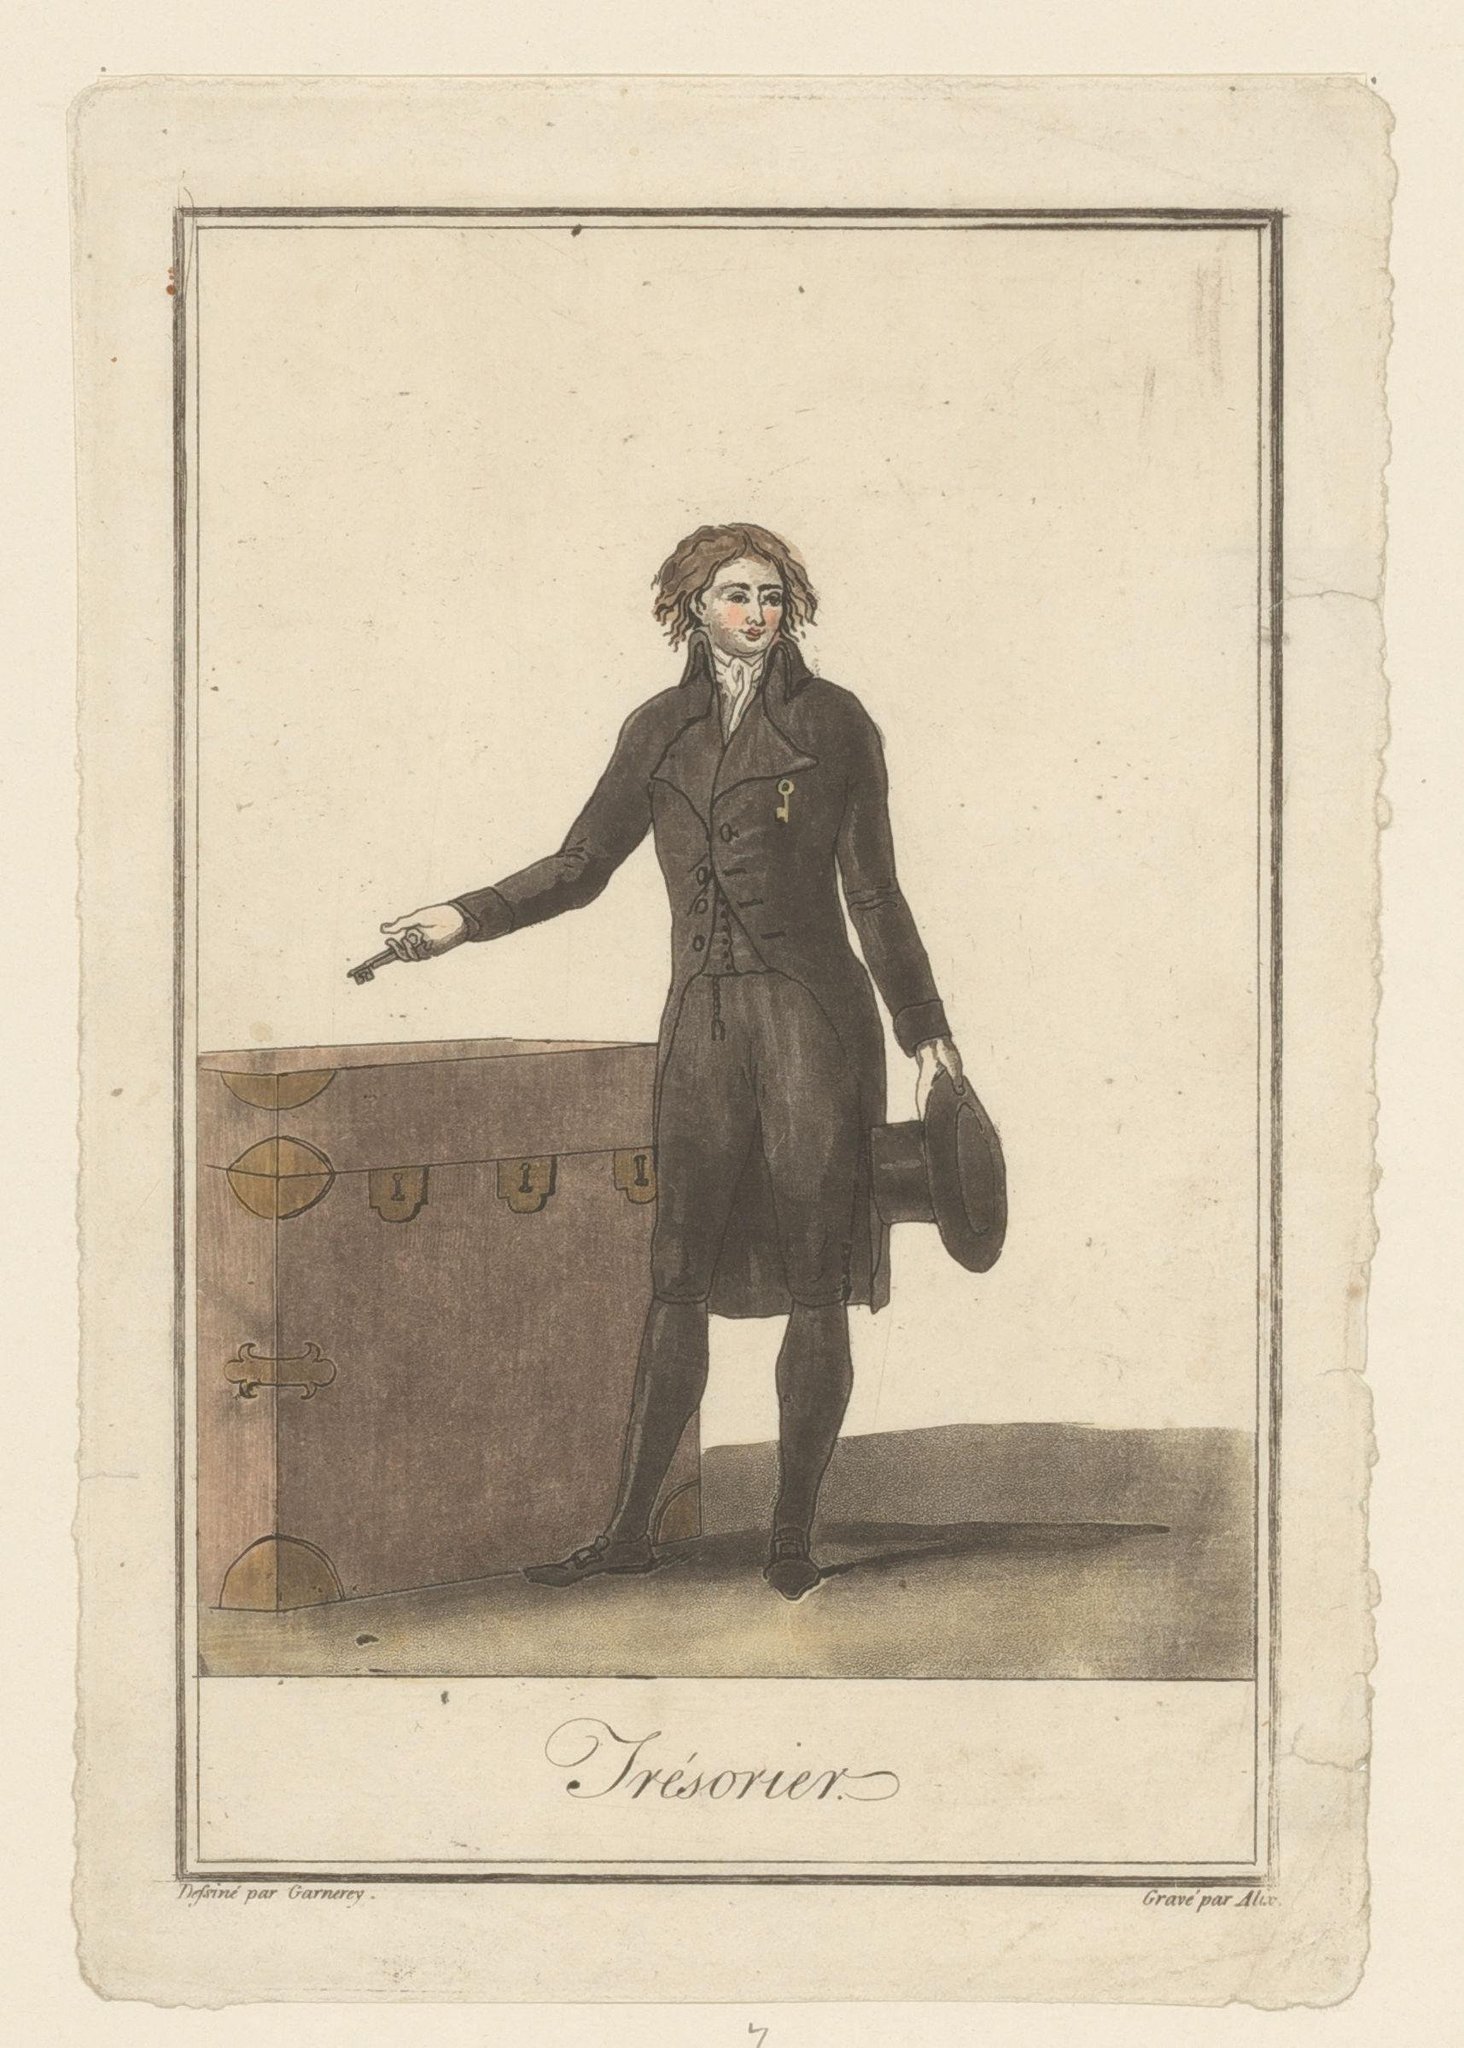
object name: print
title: Trésorier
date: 1795-1799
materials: paper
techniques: aquatint, etching, hand coloring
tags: minister ~ government, treasurer, national government, clothes, costume, head-gear: hat (+ feathers used for clothes)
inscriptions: collector's mark: Lugt 1641, stamp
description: Onderwerpsrubrieken binnen de Atlas Zeden en Gewoonten: Zeden en Gewoonten in Engeren Zin, De Kleeding, Kleederdrachten (tijdvakken), De Fransche Revolutie. (Het Directoire).